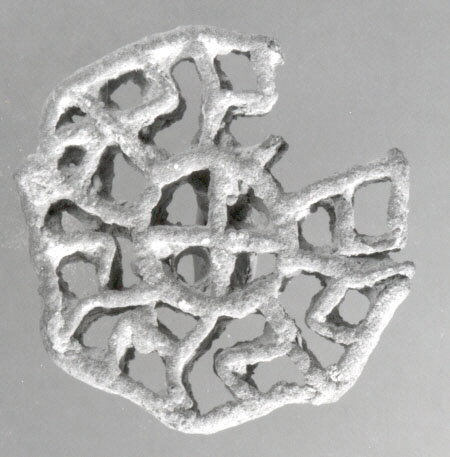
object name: stamp seal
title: Compartmented stamp seal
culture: bactria-margiana archaeological complex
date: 2333-1668 BCE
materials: copper alloy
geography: bactria-margiana